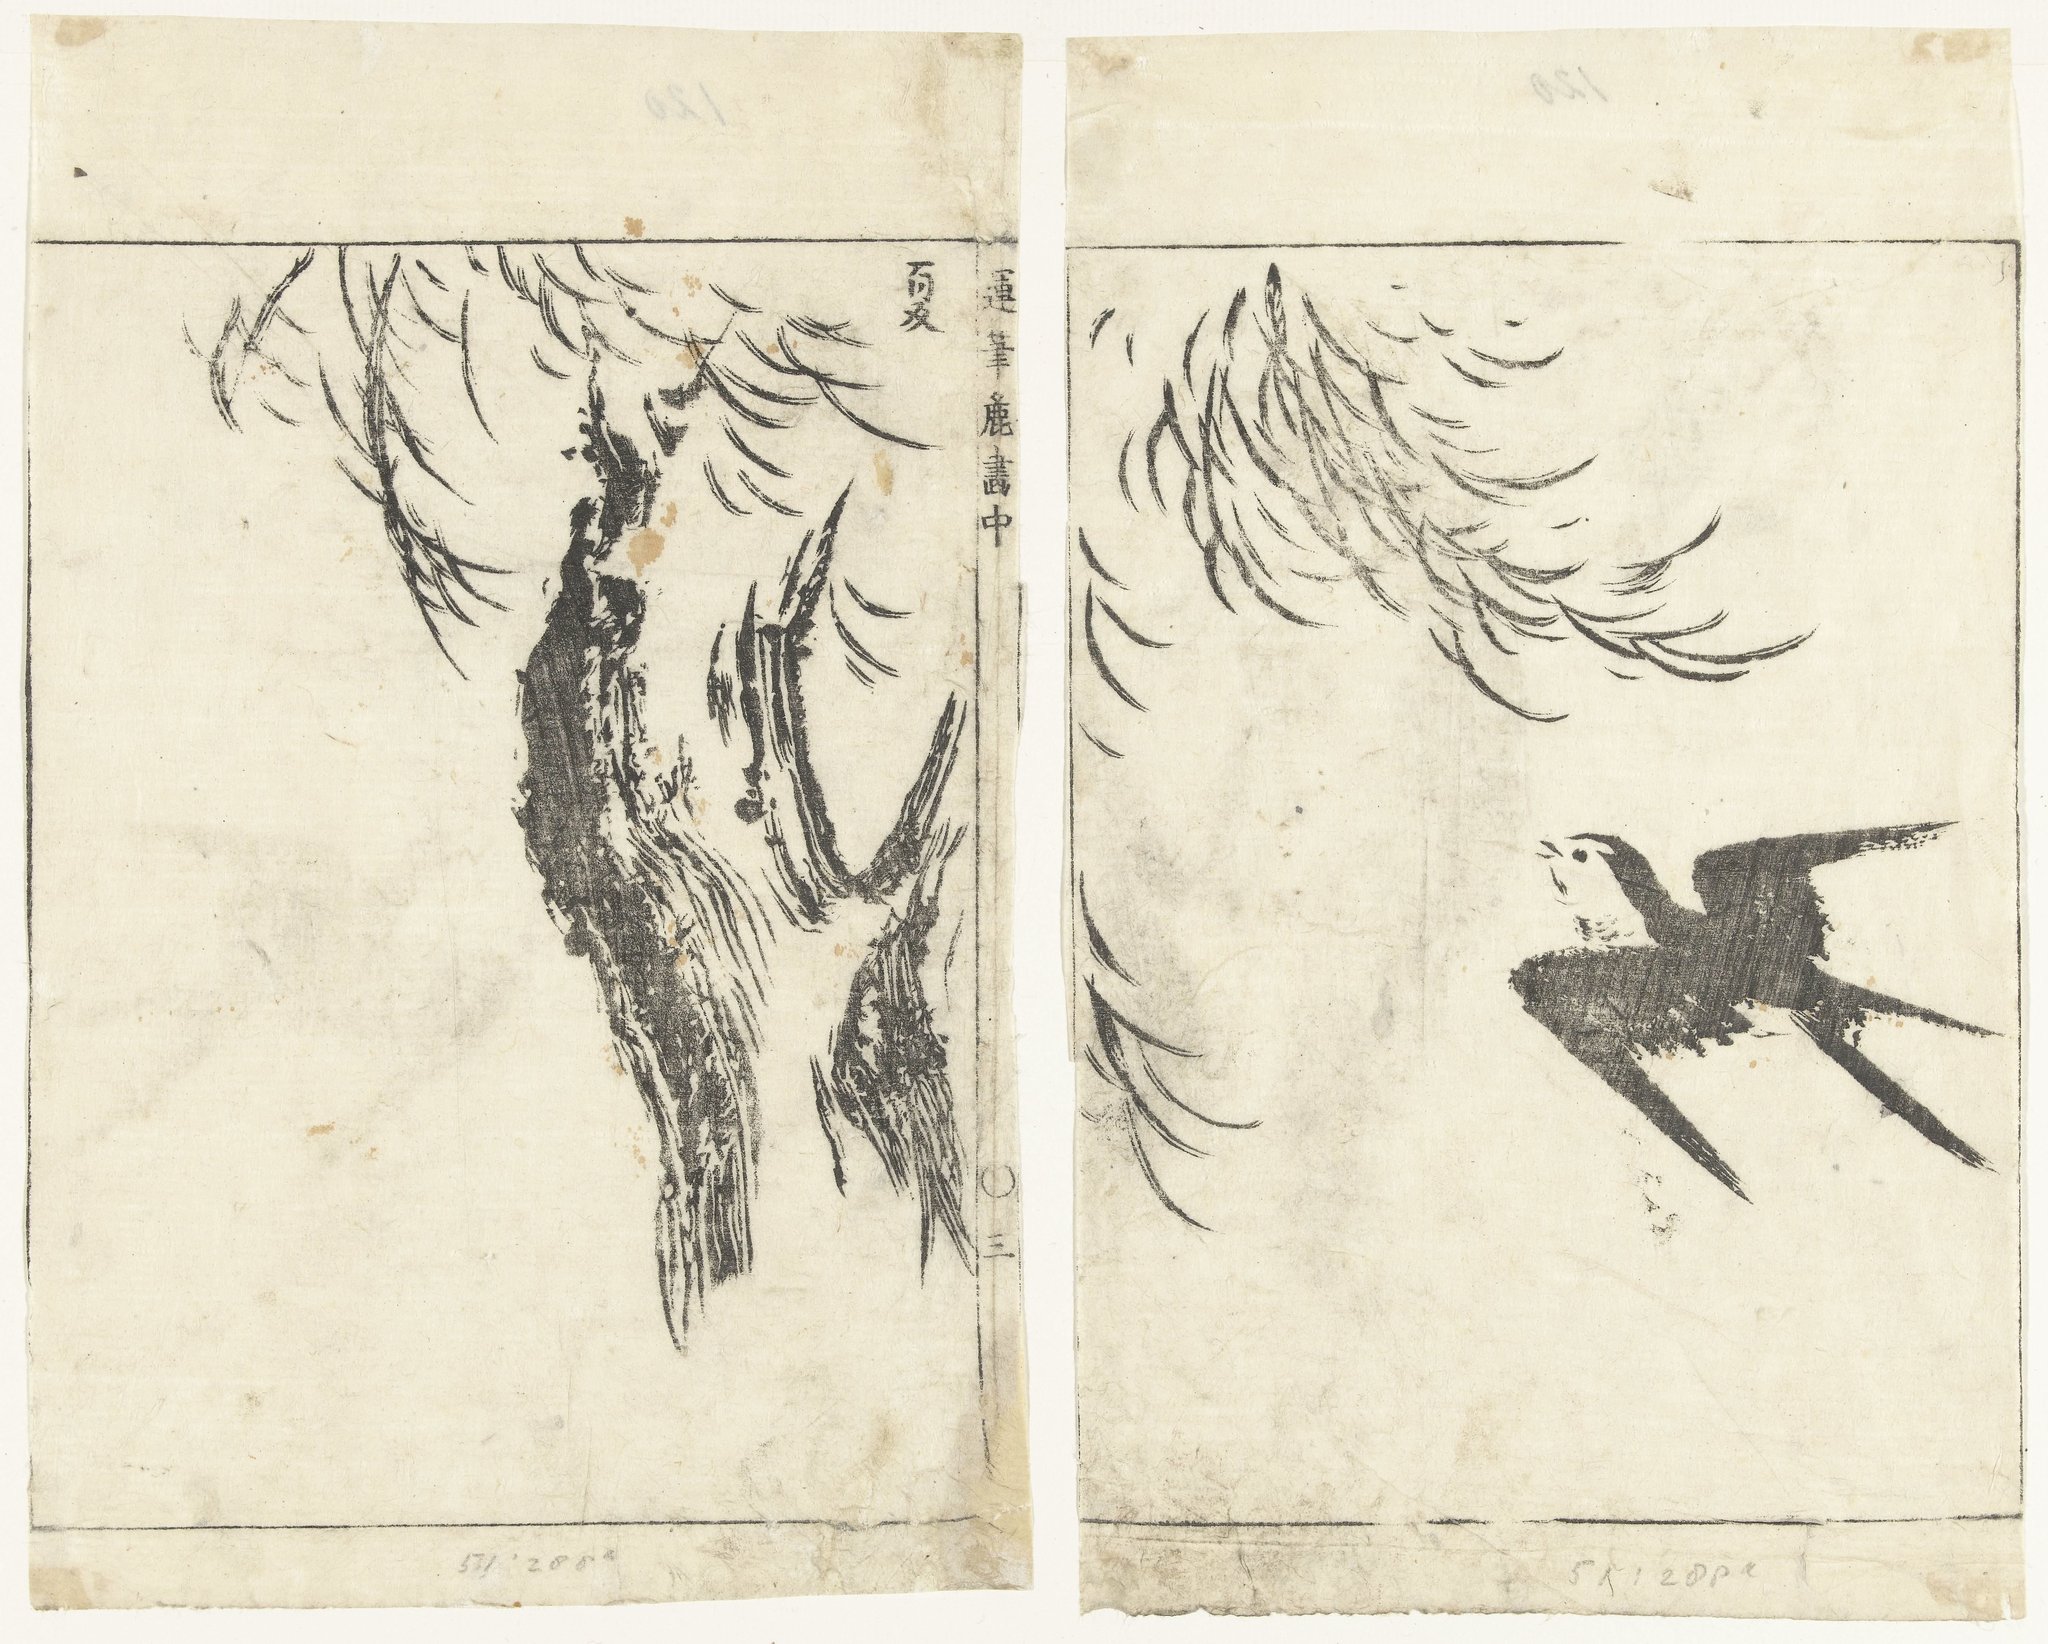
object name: print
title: Umpitsu soga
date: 1849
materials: paper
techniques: woodcut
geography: japan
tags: trees, song-birds: swallow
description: Zwaluw vliegend bij een treurwilg. Twee pagina`s uit het Japanse boek Umpitsu soga; op het linker blad het pagina nummer drie.